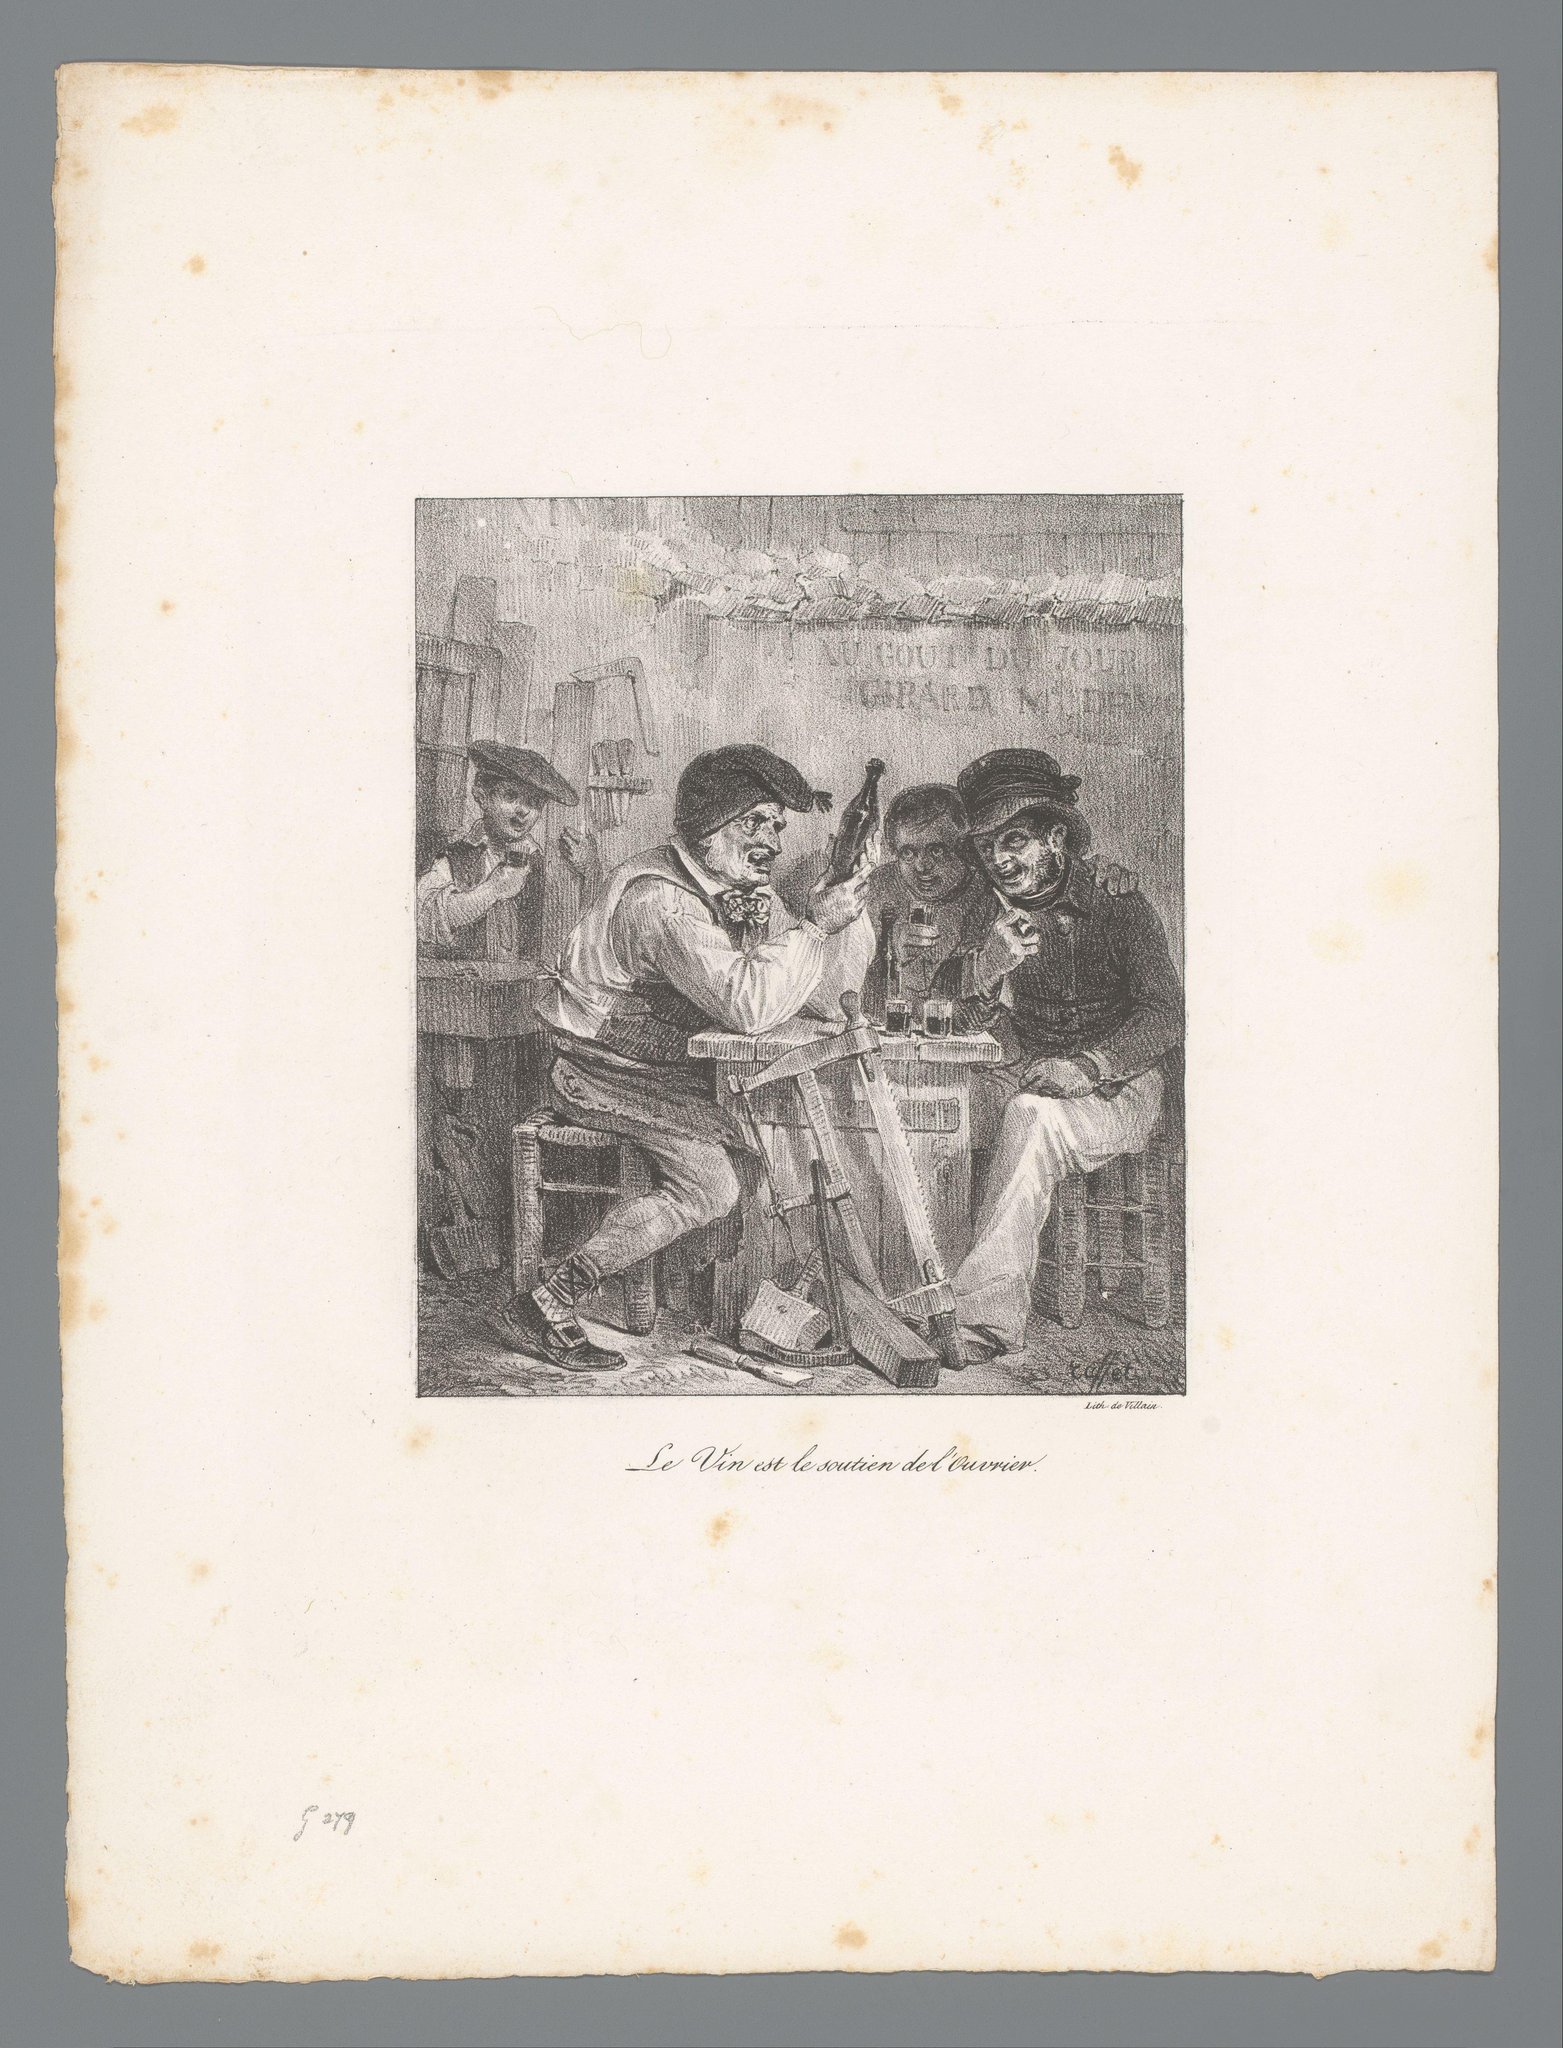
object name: print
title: Album met prenten van Auguste Raffet uit 1827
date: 1827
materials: paper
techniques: lithograph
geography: paris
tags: carpenter, bottle of wine, glass of wine, friends, tools, aids, implements ~ crafts and industries: saw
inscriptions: collector's mark: Lugt 964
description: Serie bestaat uit titelprent en tien prenten. Achtste prent in de serie van elf prenten.